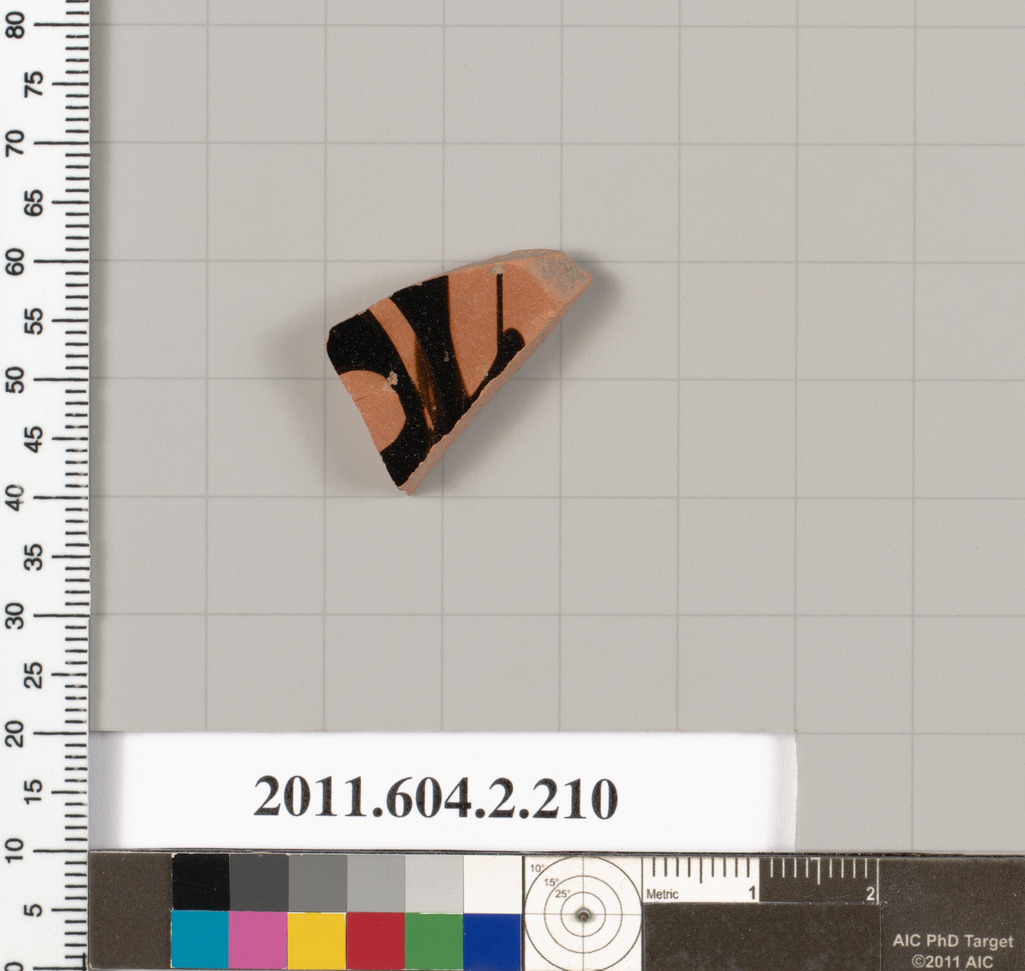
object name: stamnos fragment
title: Terracotta fragment of a stamnos (jar)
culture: greek, attic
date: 500-451 BCE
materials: terracotta